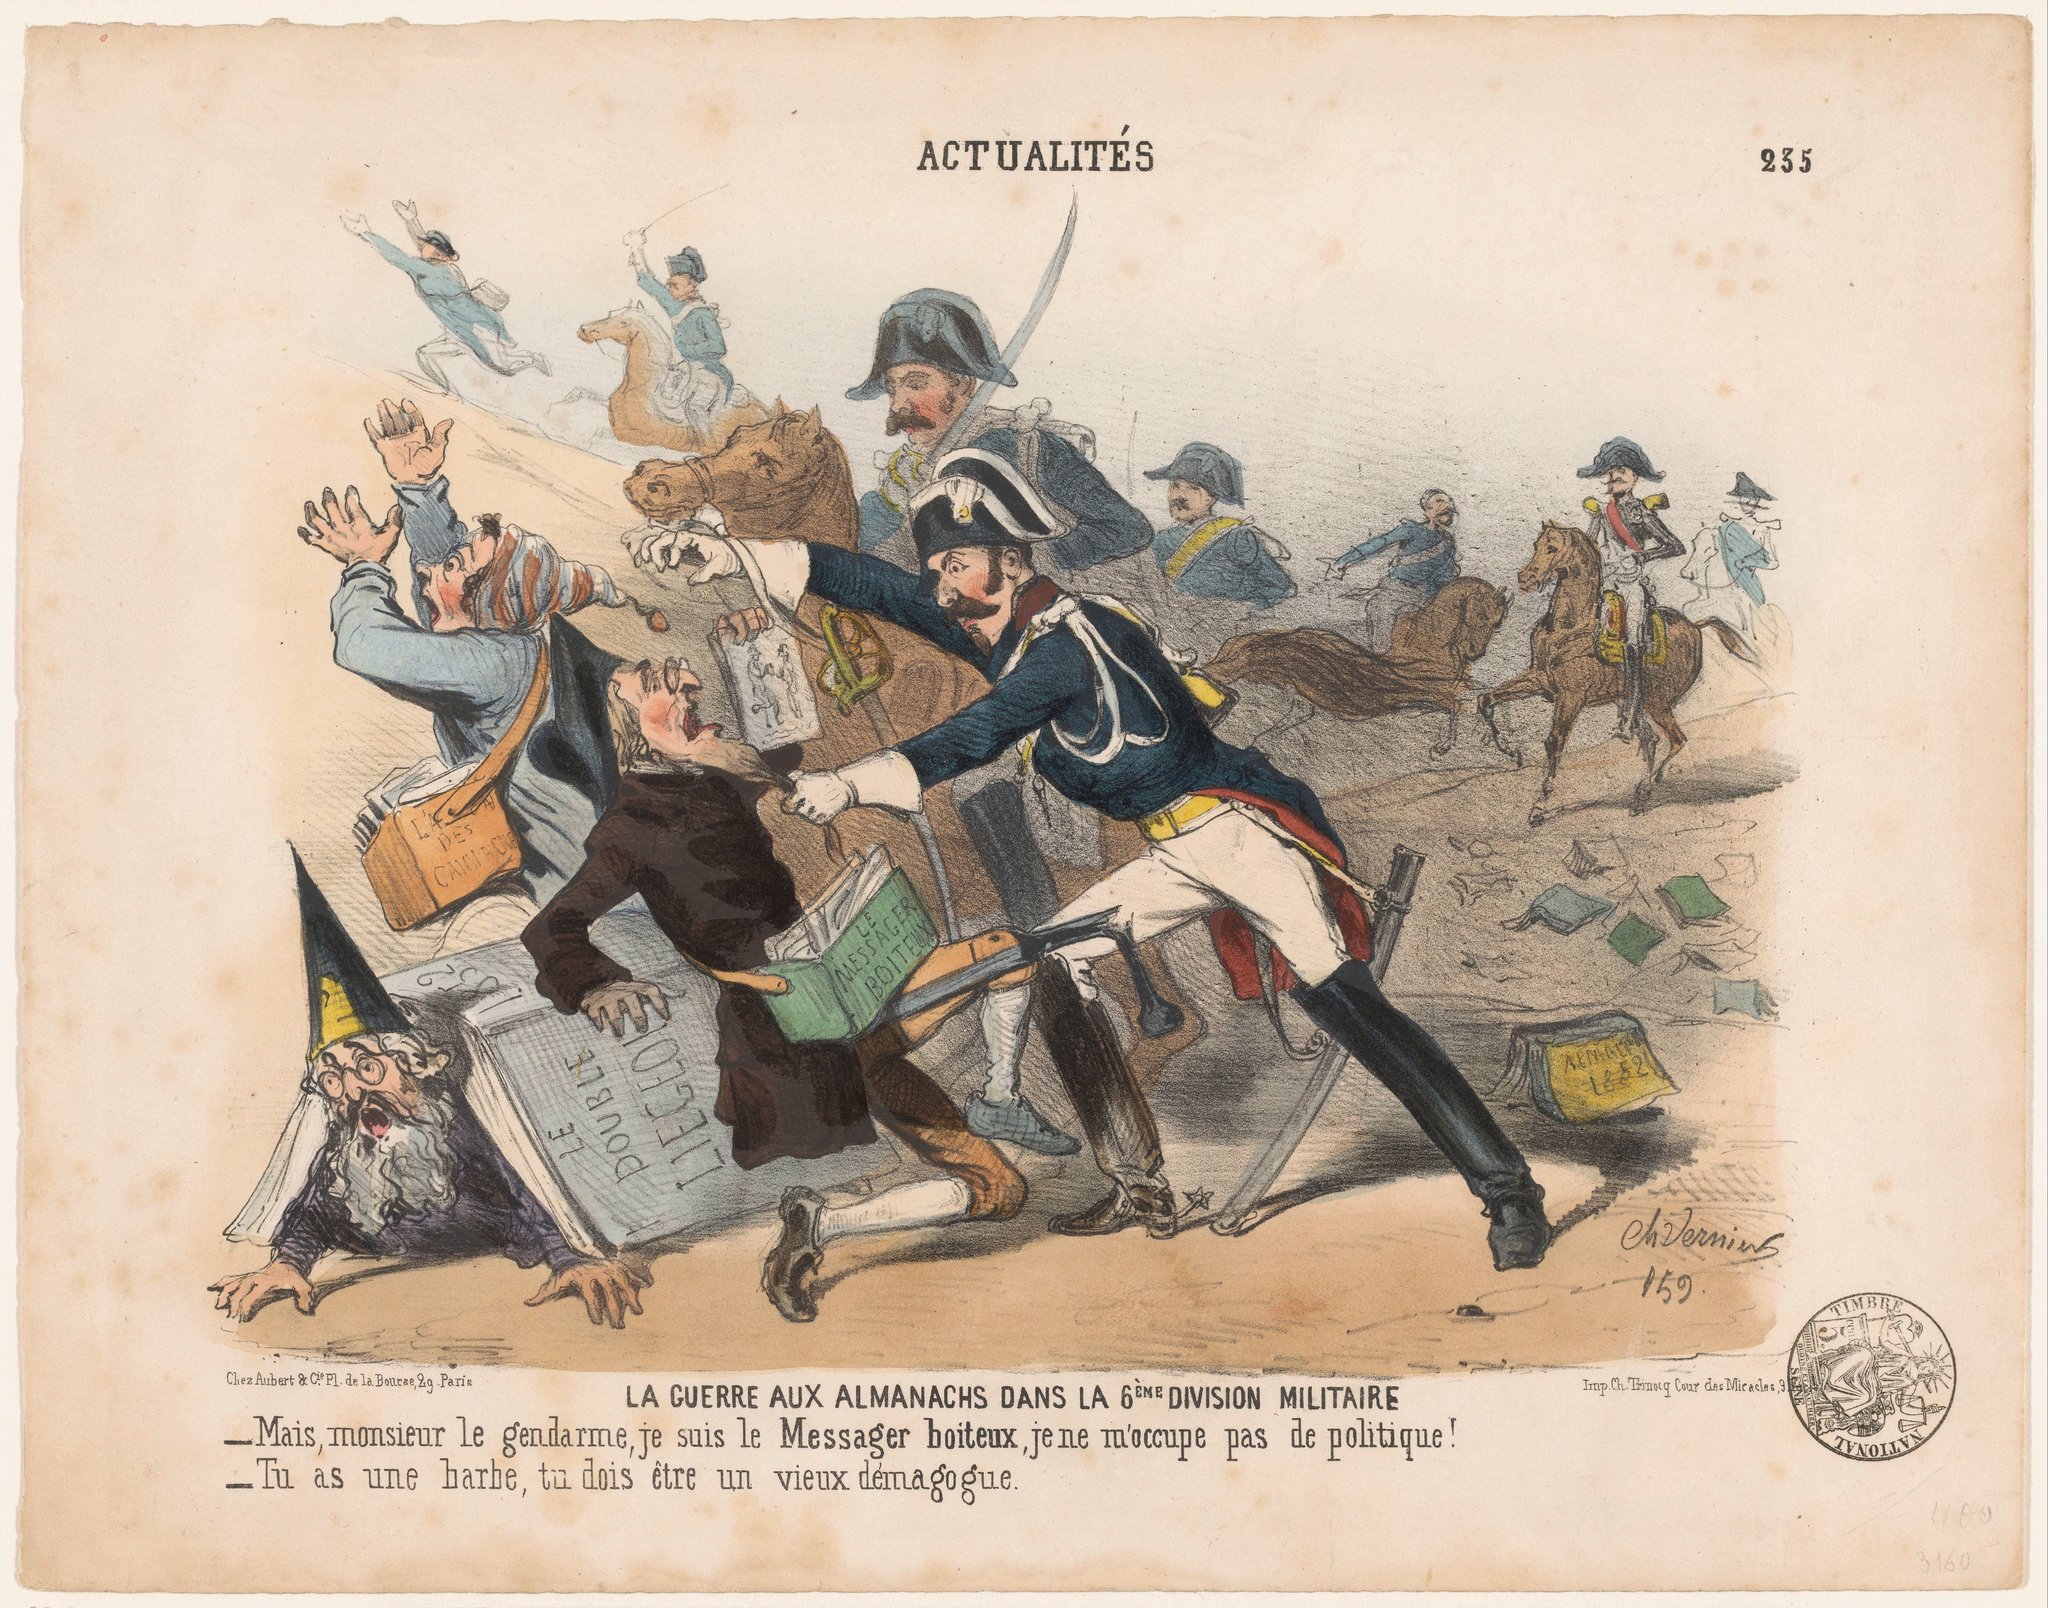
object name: print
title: Actualiteiten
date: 1852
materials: paper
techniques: hand coloring, lithograph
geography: paris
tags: calendar, almanac, censorship, policeman, constable, street-trader, political caricatures and satires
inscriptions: collector's mark: Lugt 4779, collector's mark: Lugt 2228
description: Een groep almanakverkopers wordt verjaagd door agenten te paard. Op de voorgrond wordt een almanakverkoper met een prent in zijn linkerhand en een kist met 'Le messagier Boiteux' op zijn buik bij zijn baard gegrepen door een agent te voet. Naast hen schuilt een man met een baard en een puntmuts onder een exemplaar van 'Le double Liégois'. Met tweeregelig onderschrift in het Frans.